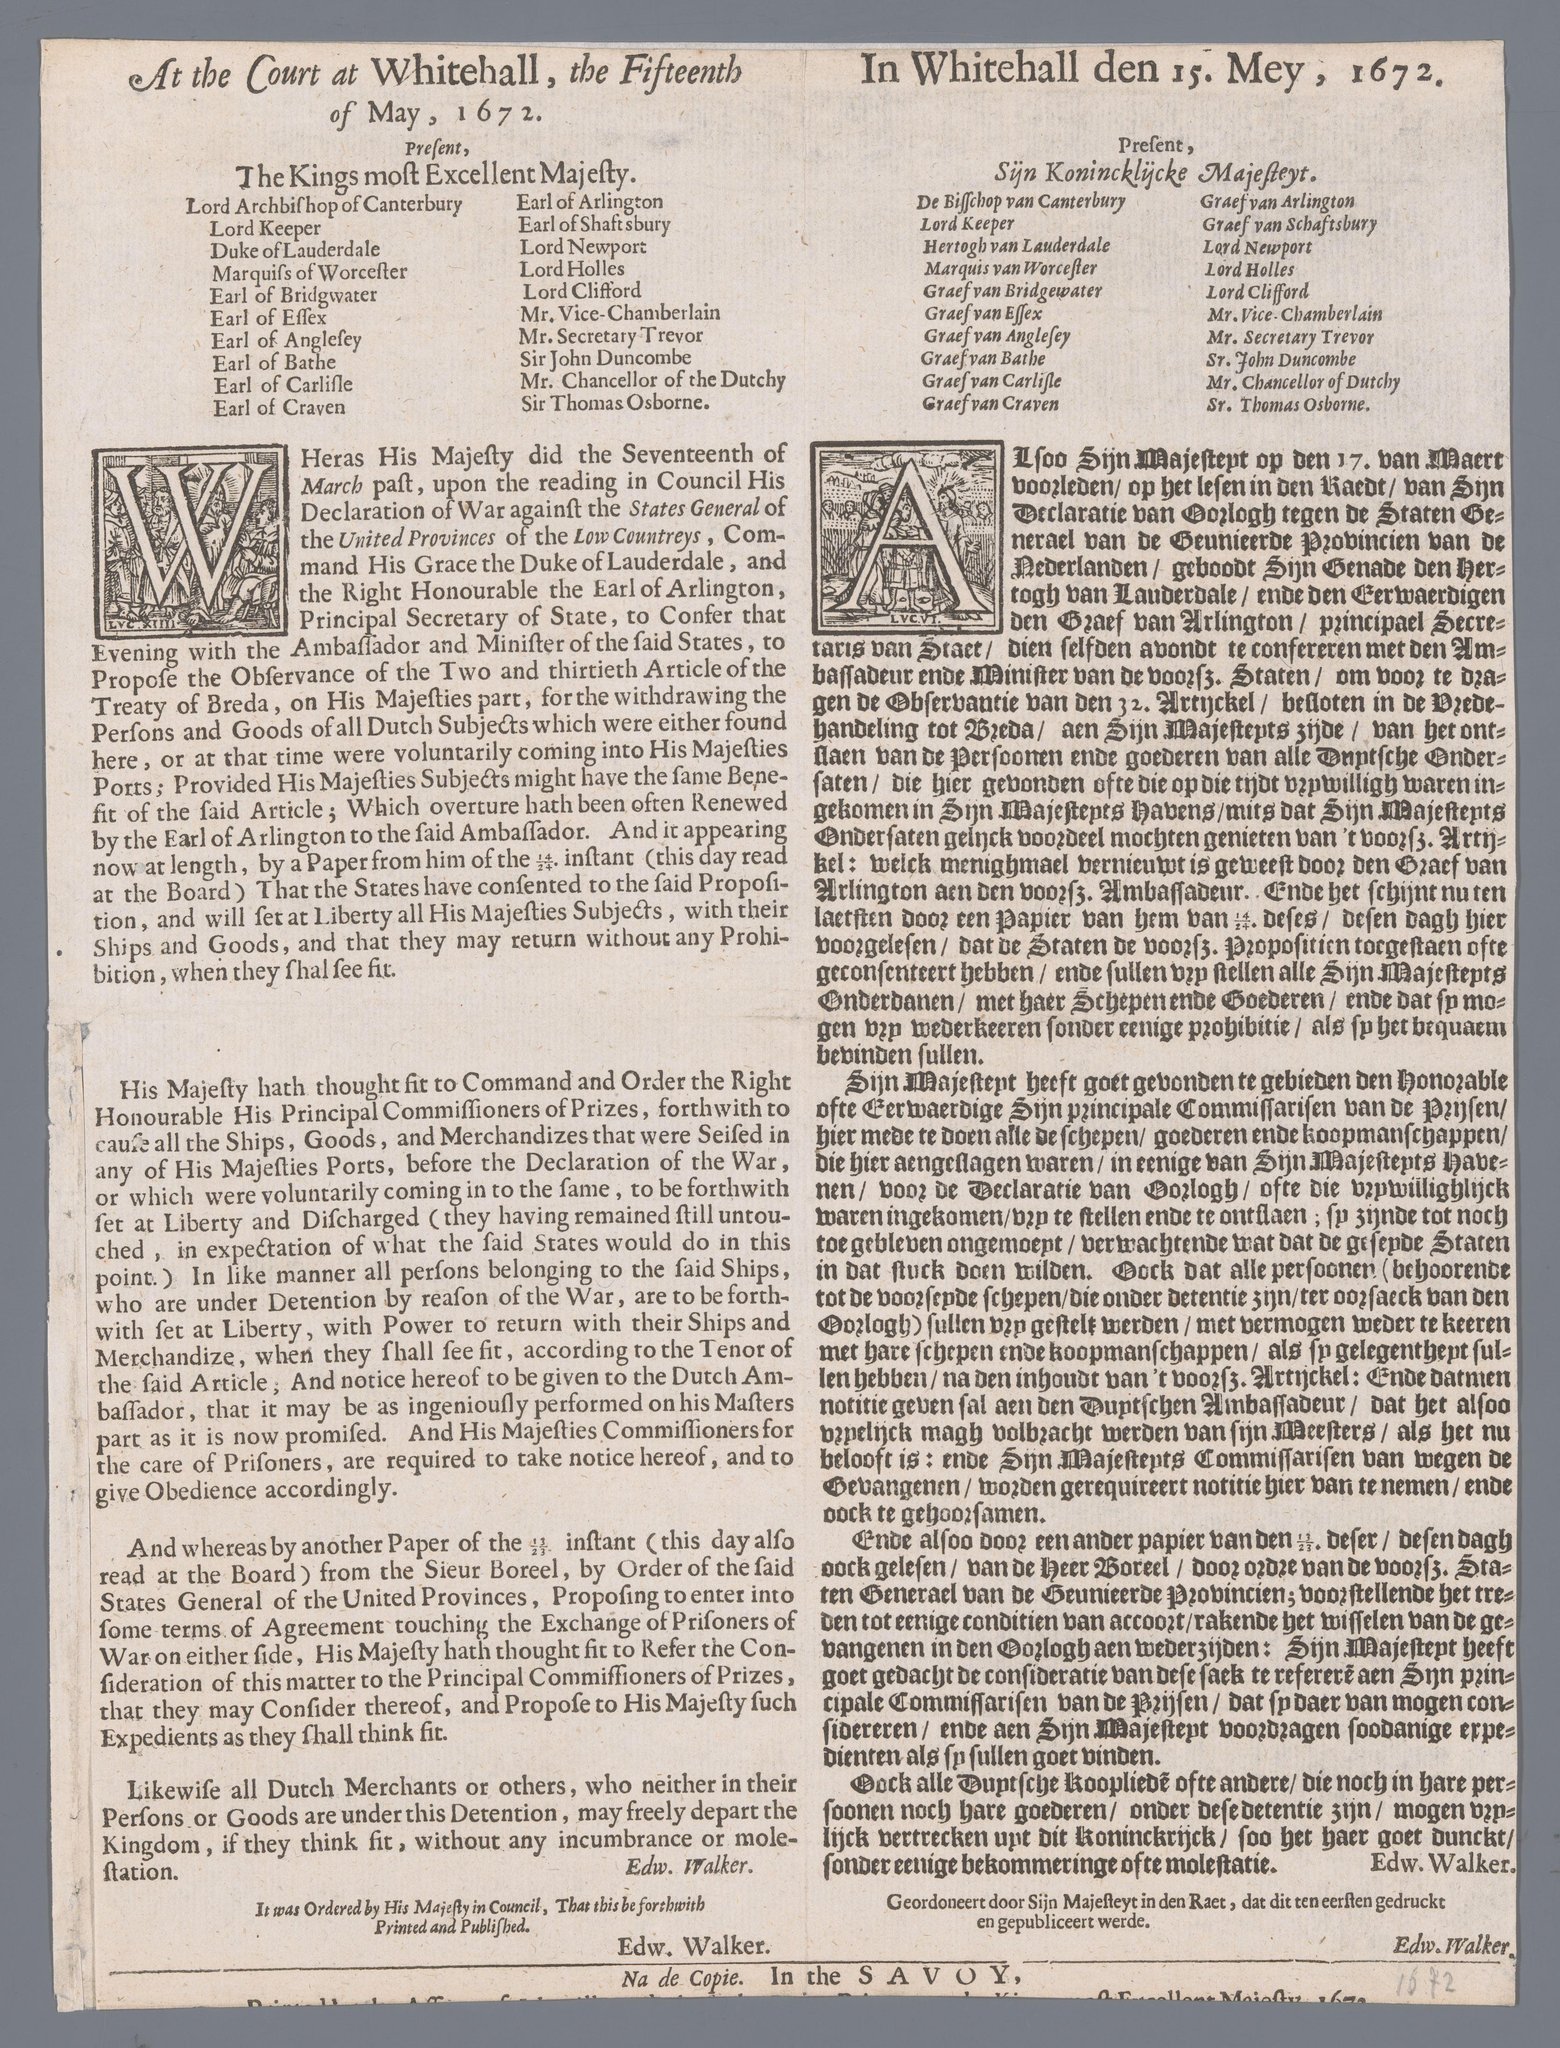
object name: pamphlet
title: Pamflet over de oorlogsverklaring van Engeland aan de Staten Generaal der Verenigde Provinciën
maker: edward walker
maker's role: publisher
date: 1672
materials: paper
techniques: printing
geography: whitehall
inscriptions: date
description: Pamflet bestaande uit 2 kolommen tekst, l. Engels, r. Nederlands. Tekst beginnende met een verluchte letter, waarin links de afbeelding van Christus binnenshuis in gezelschap van 3 staande en 1 zittende man, rechts Christus in een akker in gezelschap van 3 staande mannen, 4 figuren op de achtergrond. Opschrift: In Whitehall den 15. Mey, 1672 Present, Sijn Konincklijke Majesteyt. (...) Alsoo Sijn Majesteyt op den 17. van Maert voorleden, op het lesen in de Raedt, van Sijn Declaratie van Oorlogh tegen ...etc.